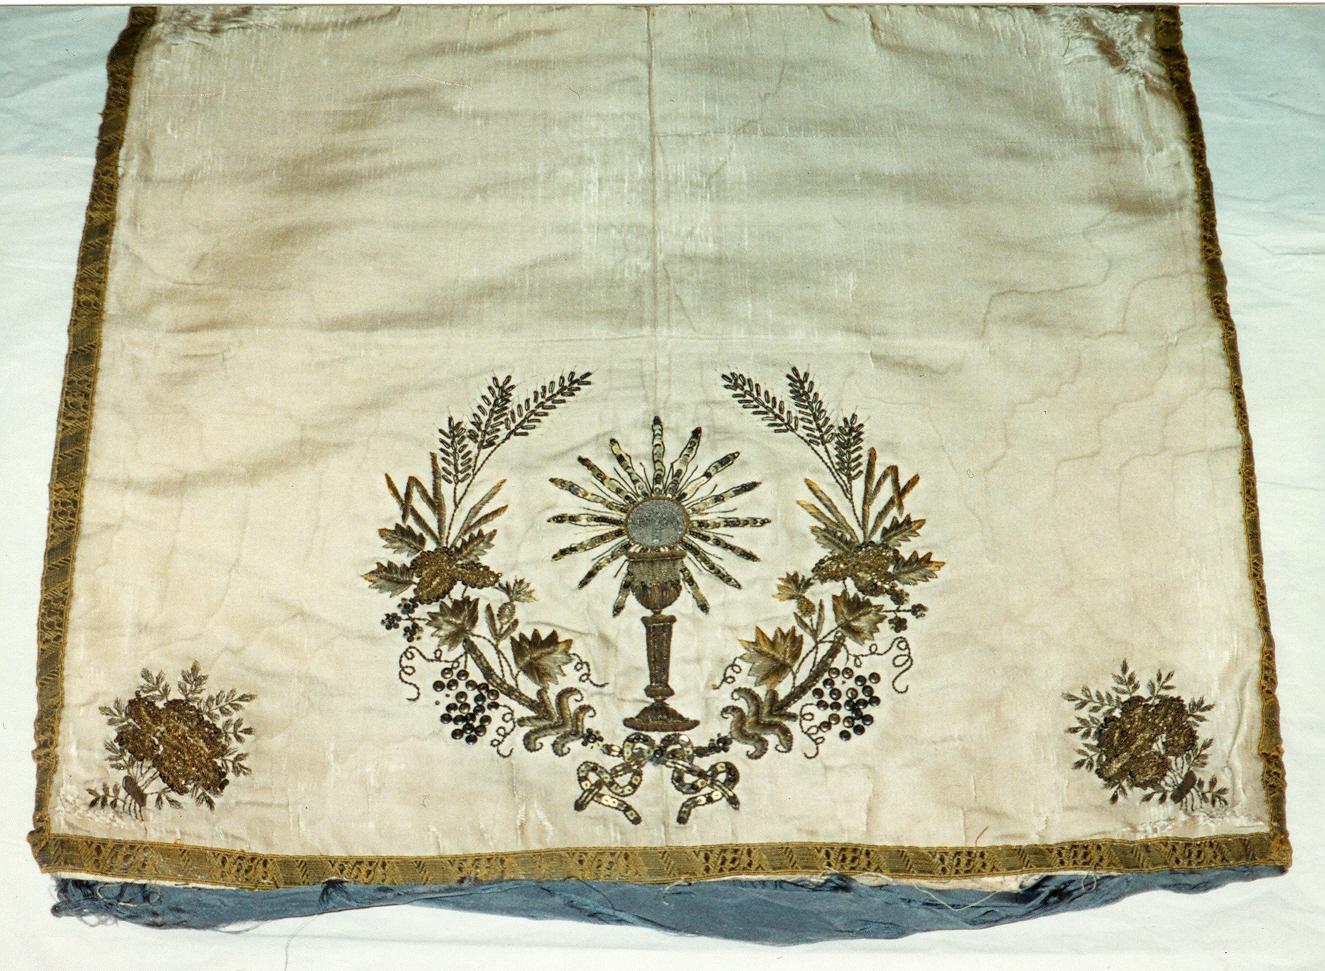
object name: chalice veil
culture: french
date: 1801-1900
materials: metal, silk